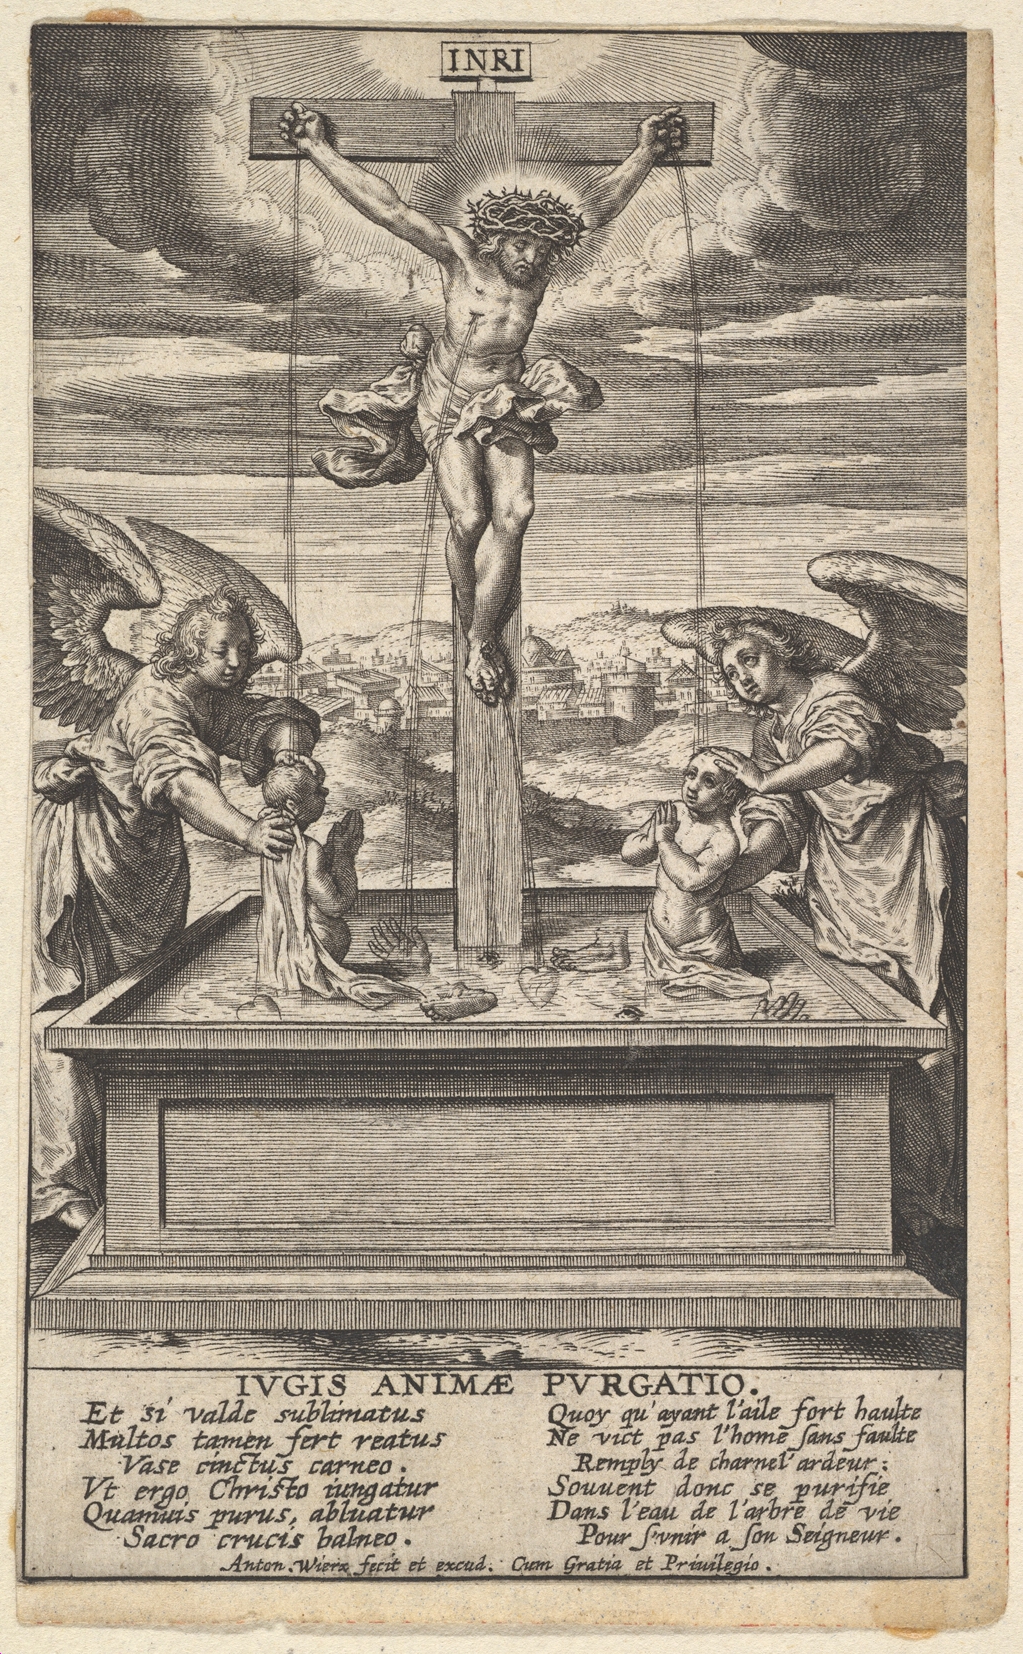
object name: print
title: The Fountain of Life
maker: antonius wierix, ii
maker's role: artist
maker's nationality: netherlandish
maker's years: 1555-1604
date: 1604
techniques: engraving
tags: angels,christ,crucifixion,bathing